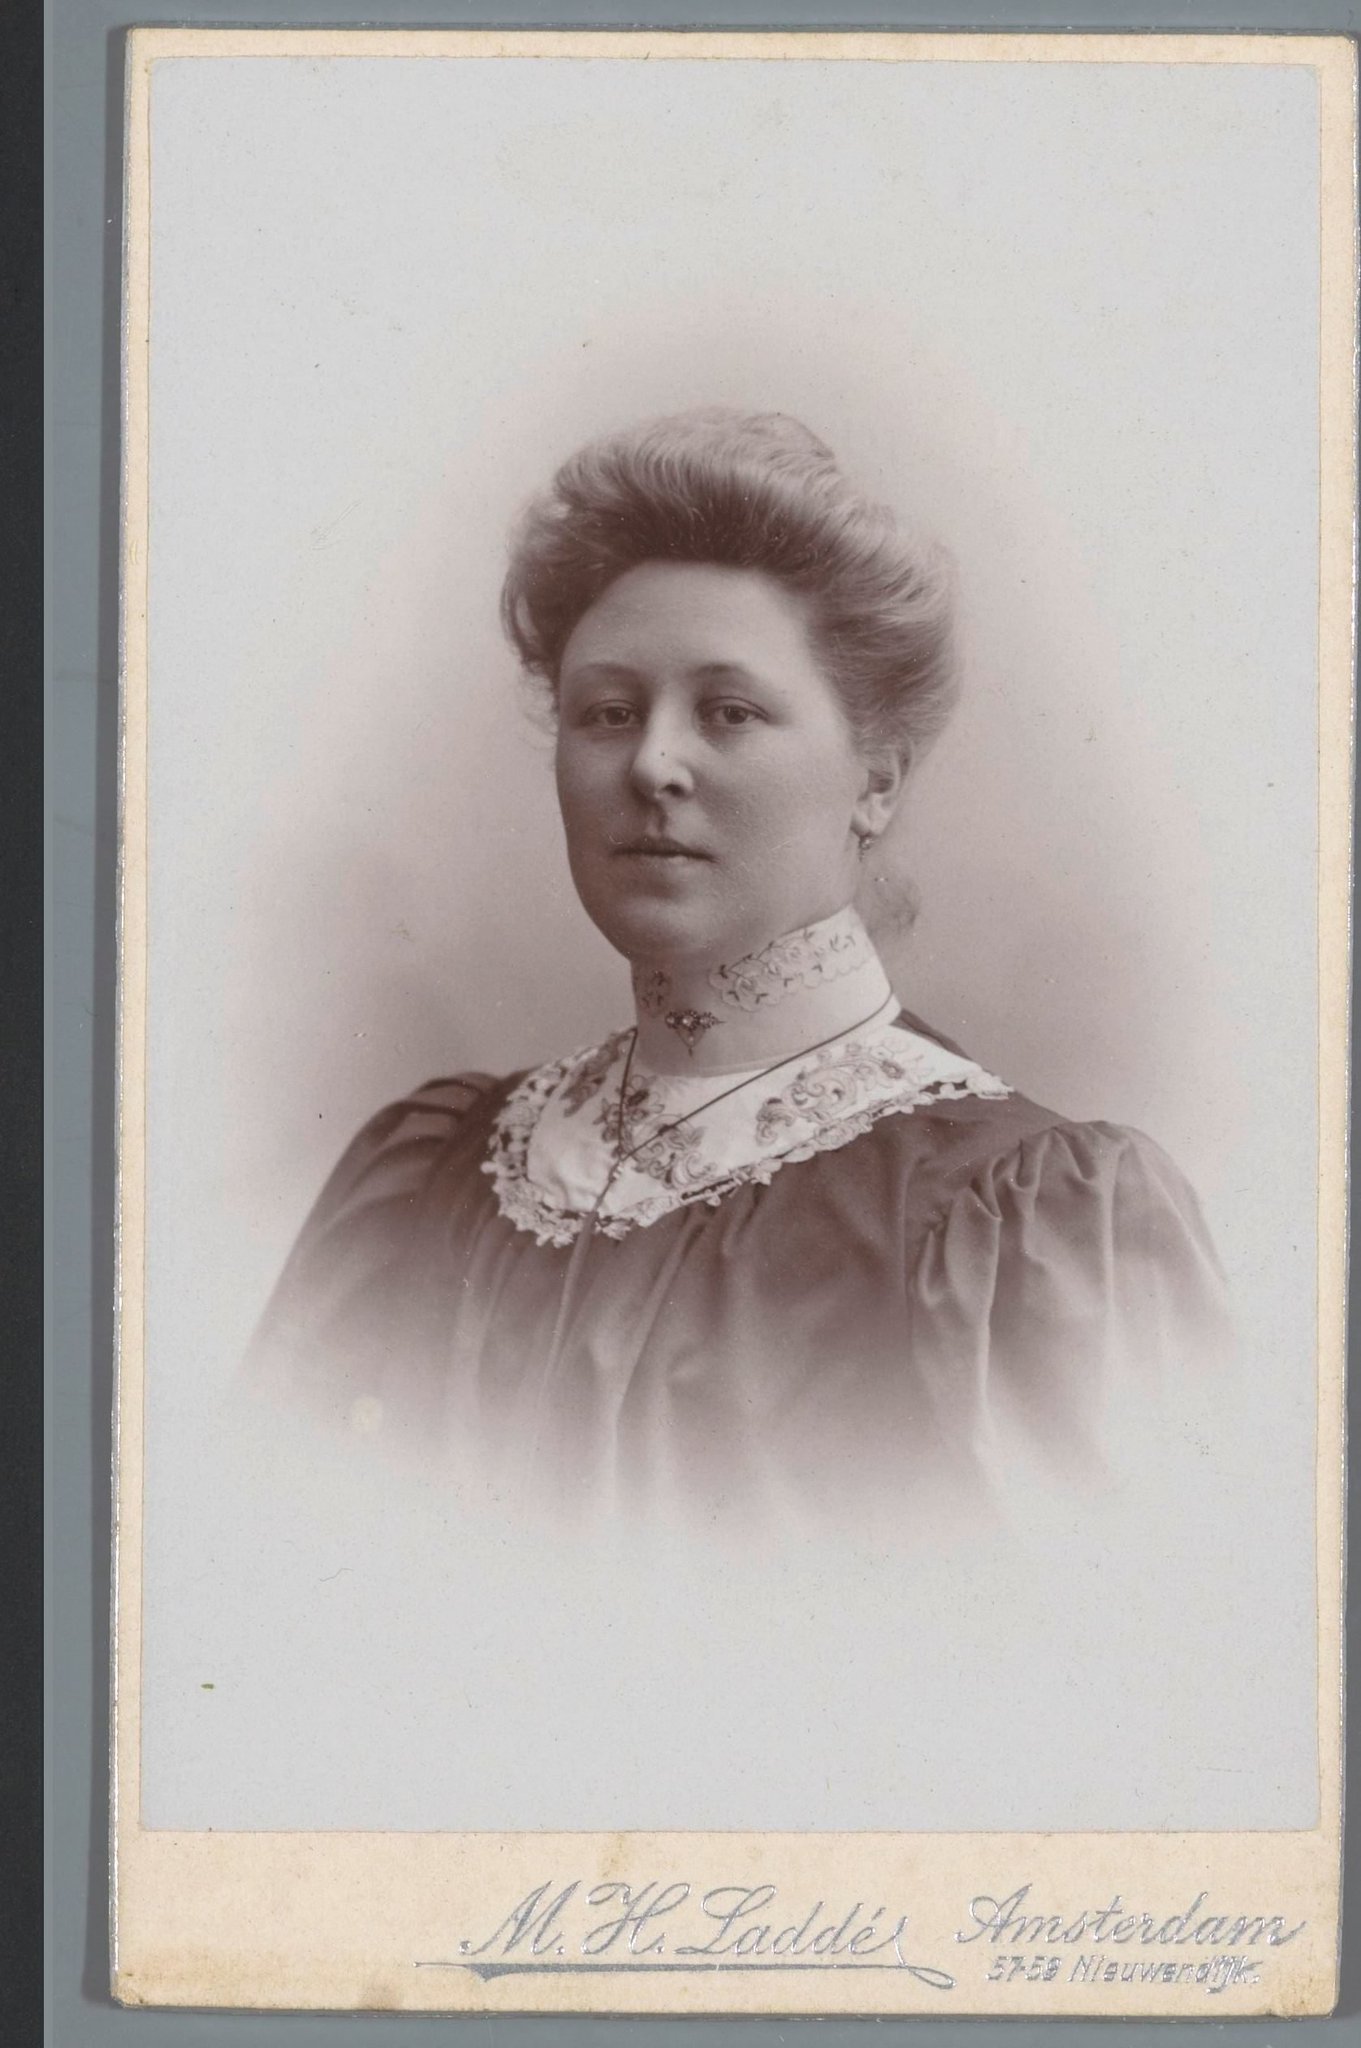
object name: photograph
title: Portret van een onbekende vrouw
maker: machiel hendricus laddé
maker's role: fotograaf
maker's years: 1866-1932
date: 1892-1906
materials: cardboard, photographic support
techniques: collodion silver print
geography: amsterdam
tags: historical persons - bb - woman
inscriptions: address: ‘M. H. Laddé Amsterdam/ 57-59 Nieuwendijk’